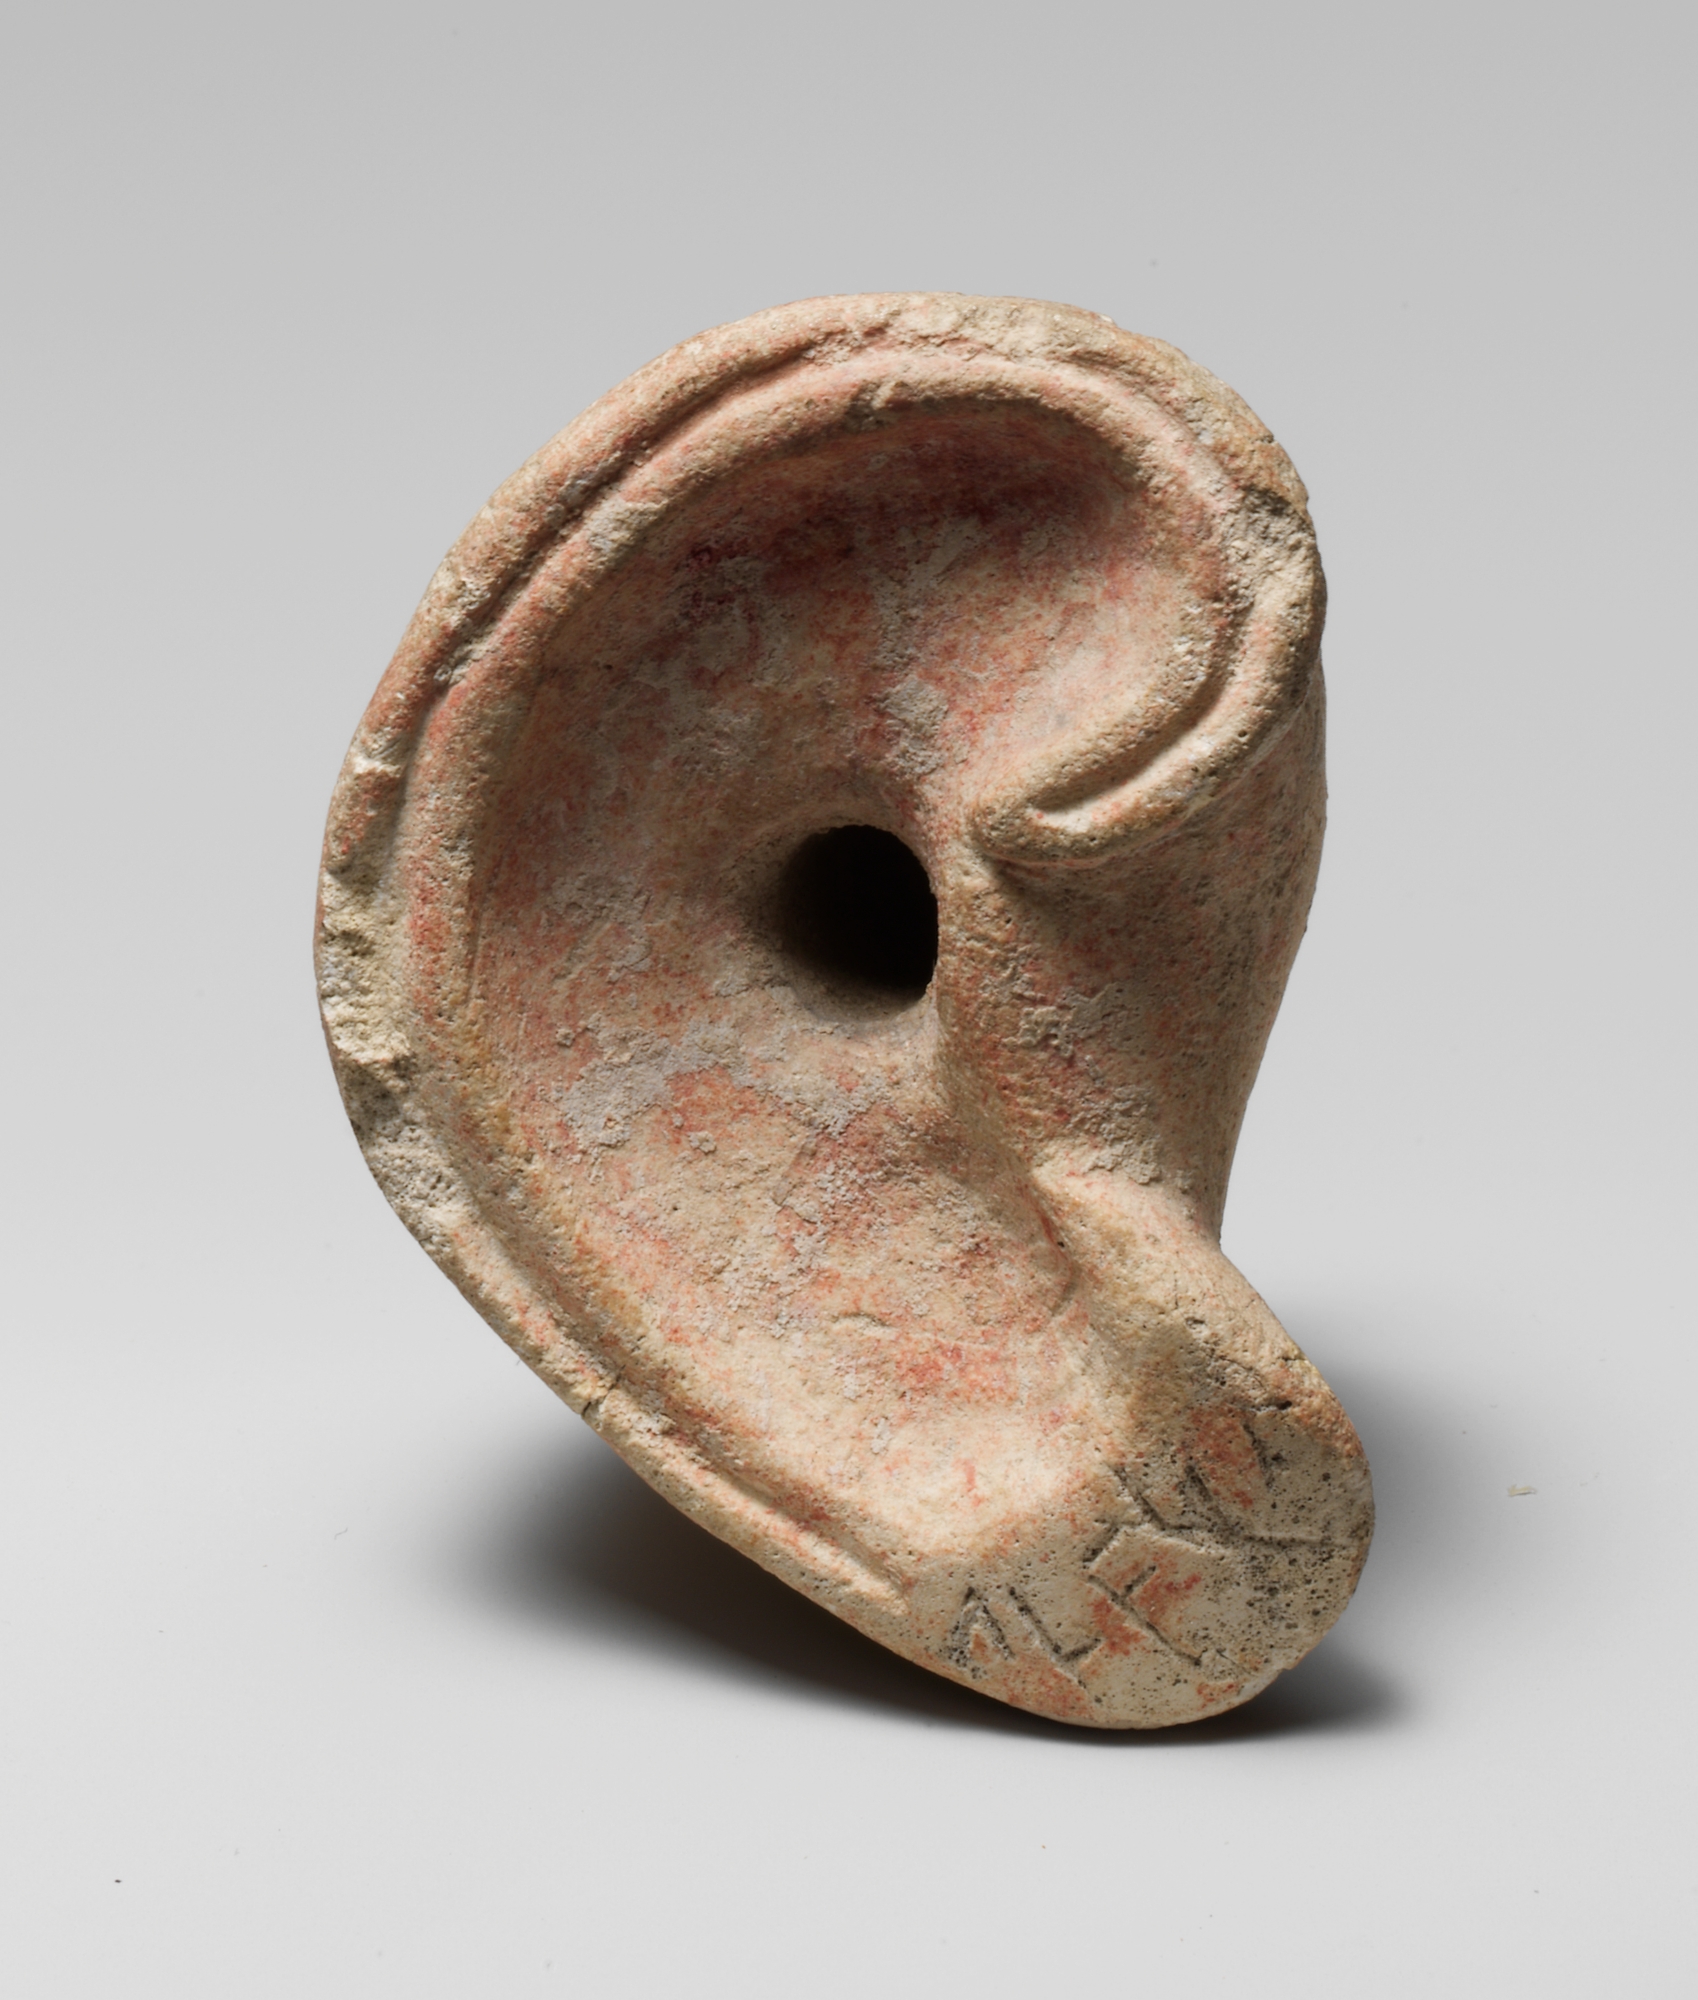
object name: votive ear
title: Limestone votive ear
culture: cypriot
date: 400-201 BCE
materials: limestone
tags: ears